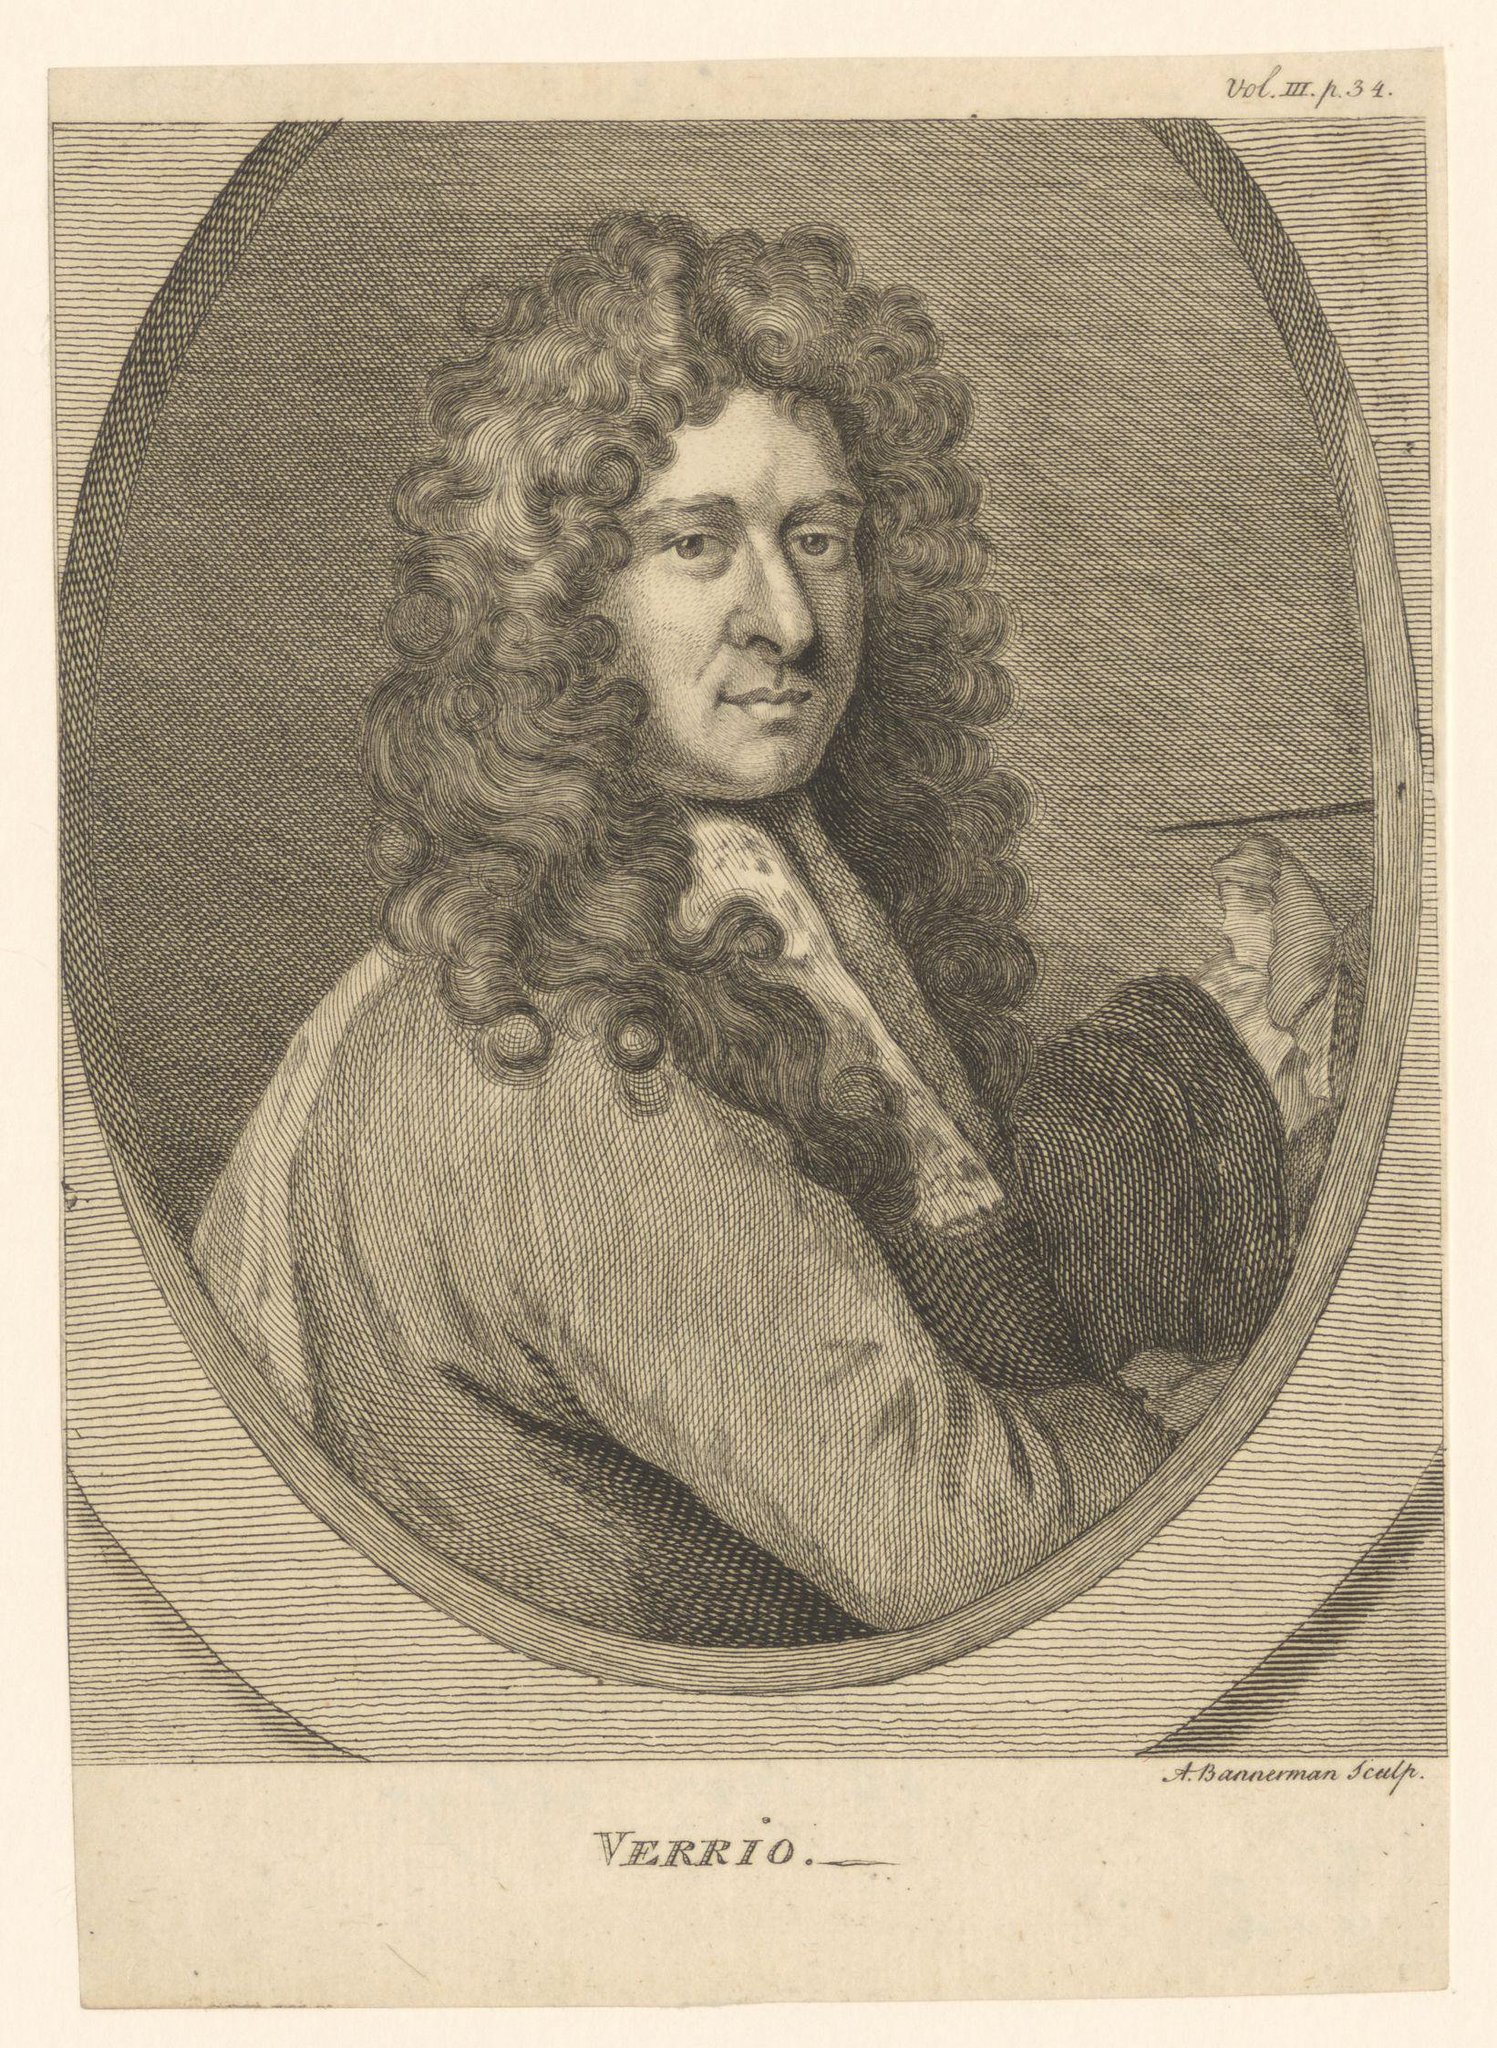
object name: print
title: Portret van Antonio Verrio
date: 1763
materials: paper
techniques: engraving, etching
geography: strawberry hill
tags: lecce, painter, antonio verrio, historical persons, portrait, self-portrait of painter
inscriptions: collector's mark: Lugt 2228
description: Prent uit: Vertue, George. Anecdotes of Painting in England (...). Londen: Horace Walpole, 1763, dl. 3, p. 34.